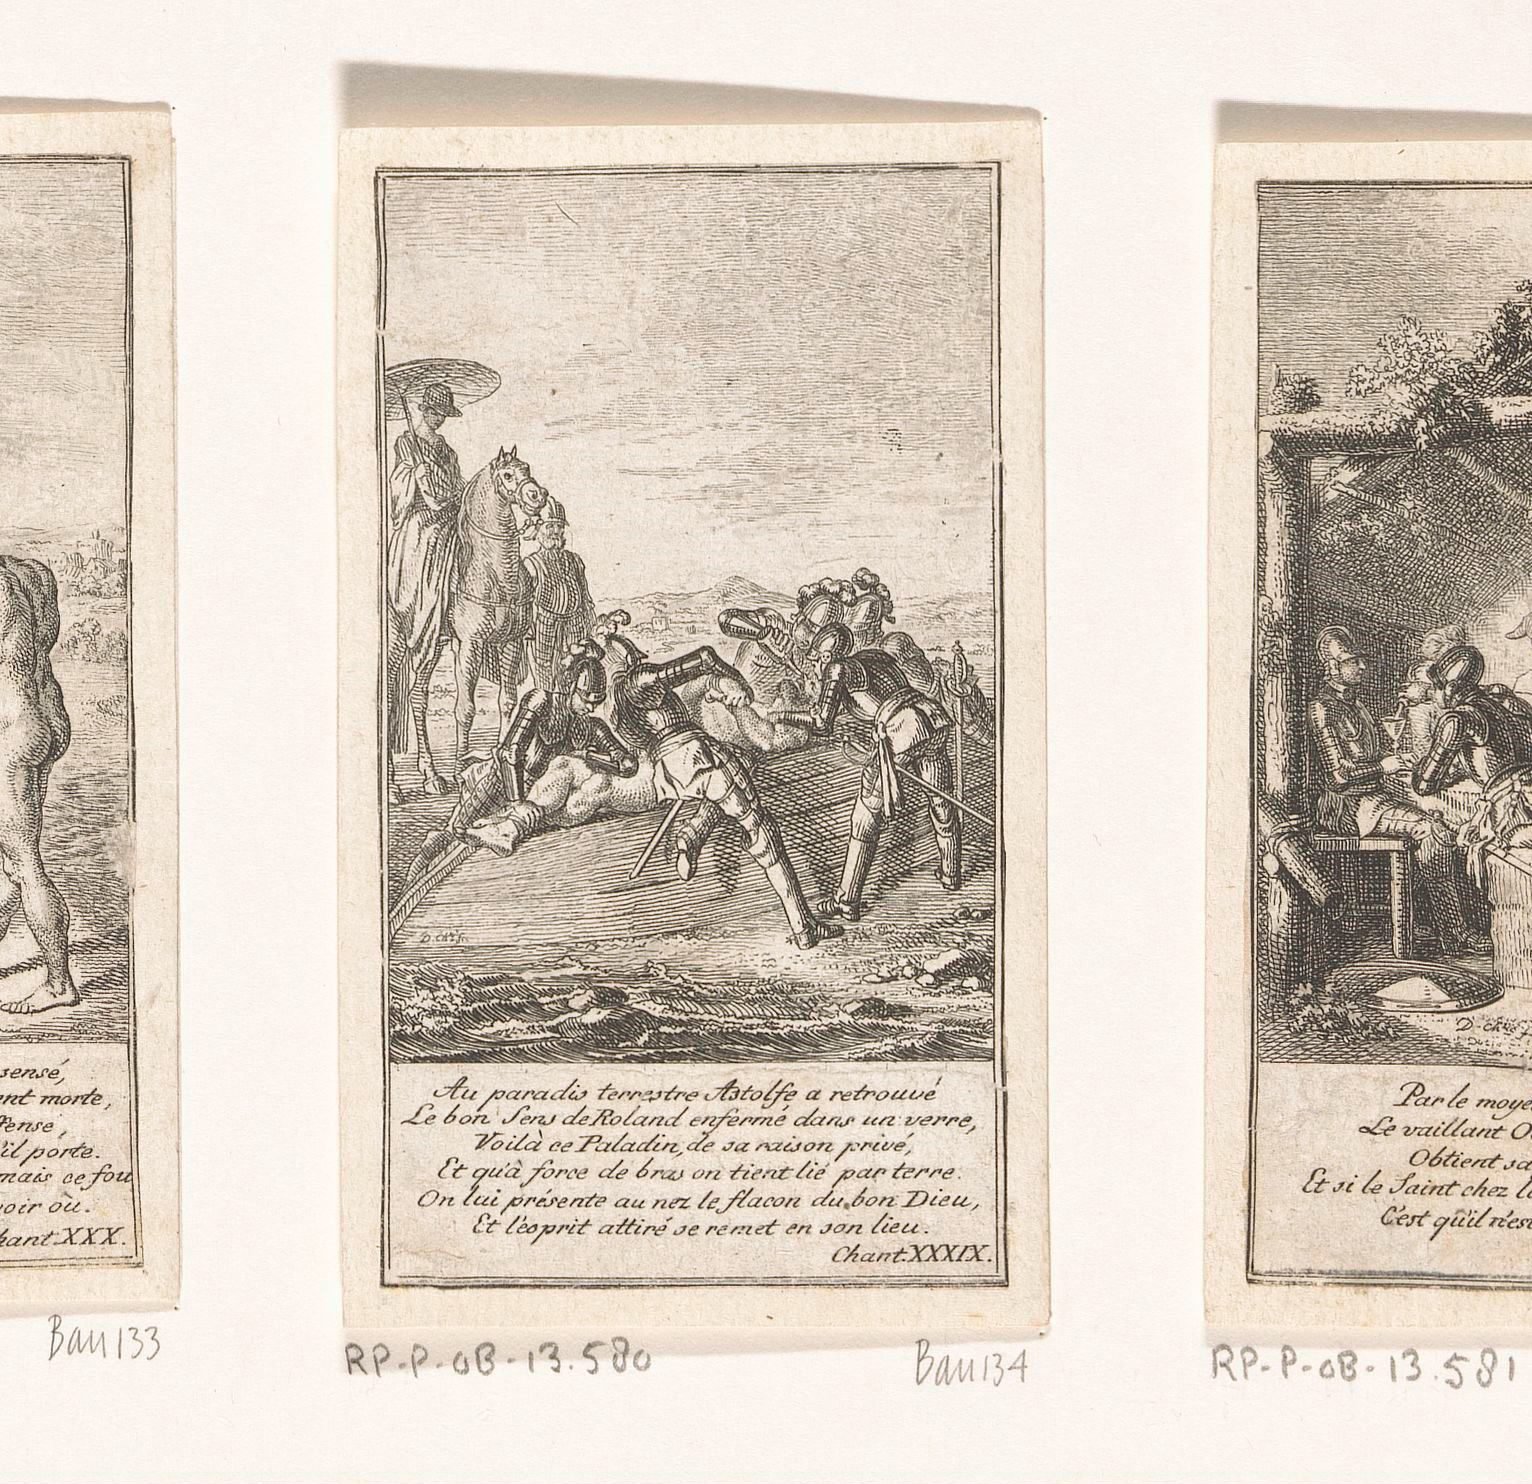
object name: print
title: Ariosto weer bij zinnen gebracht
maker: daniel nikolaus chodowiecki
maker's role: draughtsman, print maker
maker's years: 1726-1801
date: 1771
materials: paper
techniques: etching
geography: berlin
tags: ludovico ariosto, (scenes from) specific works of literature: ariosto, orlando furioso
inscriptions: collector's mark: Lugt 2228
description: Canto negenendertig uit 'Ariosto Furioso'. Vijf ridders houden Ariosto in bedwang die vastgebonden op een omgekeerde boot ligt. Astolfus houdt Ariosto een fles onder zijn neus waarin zijn verstand bewaard wordt. Zodra hij de inhoud heeft opgesnoven komt hij weer bij zinnen.